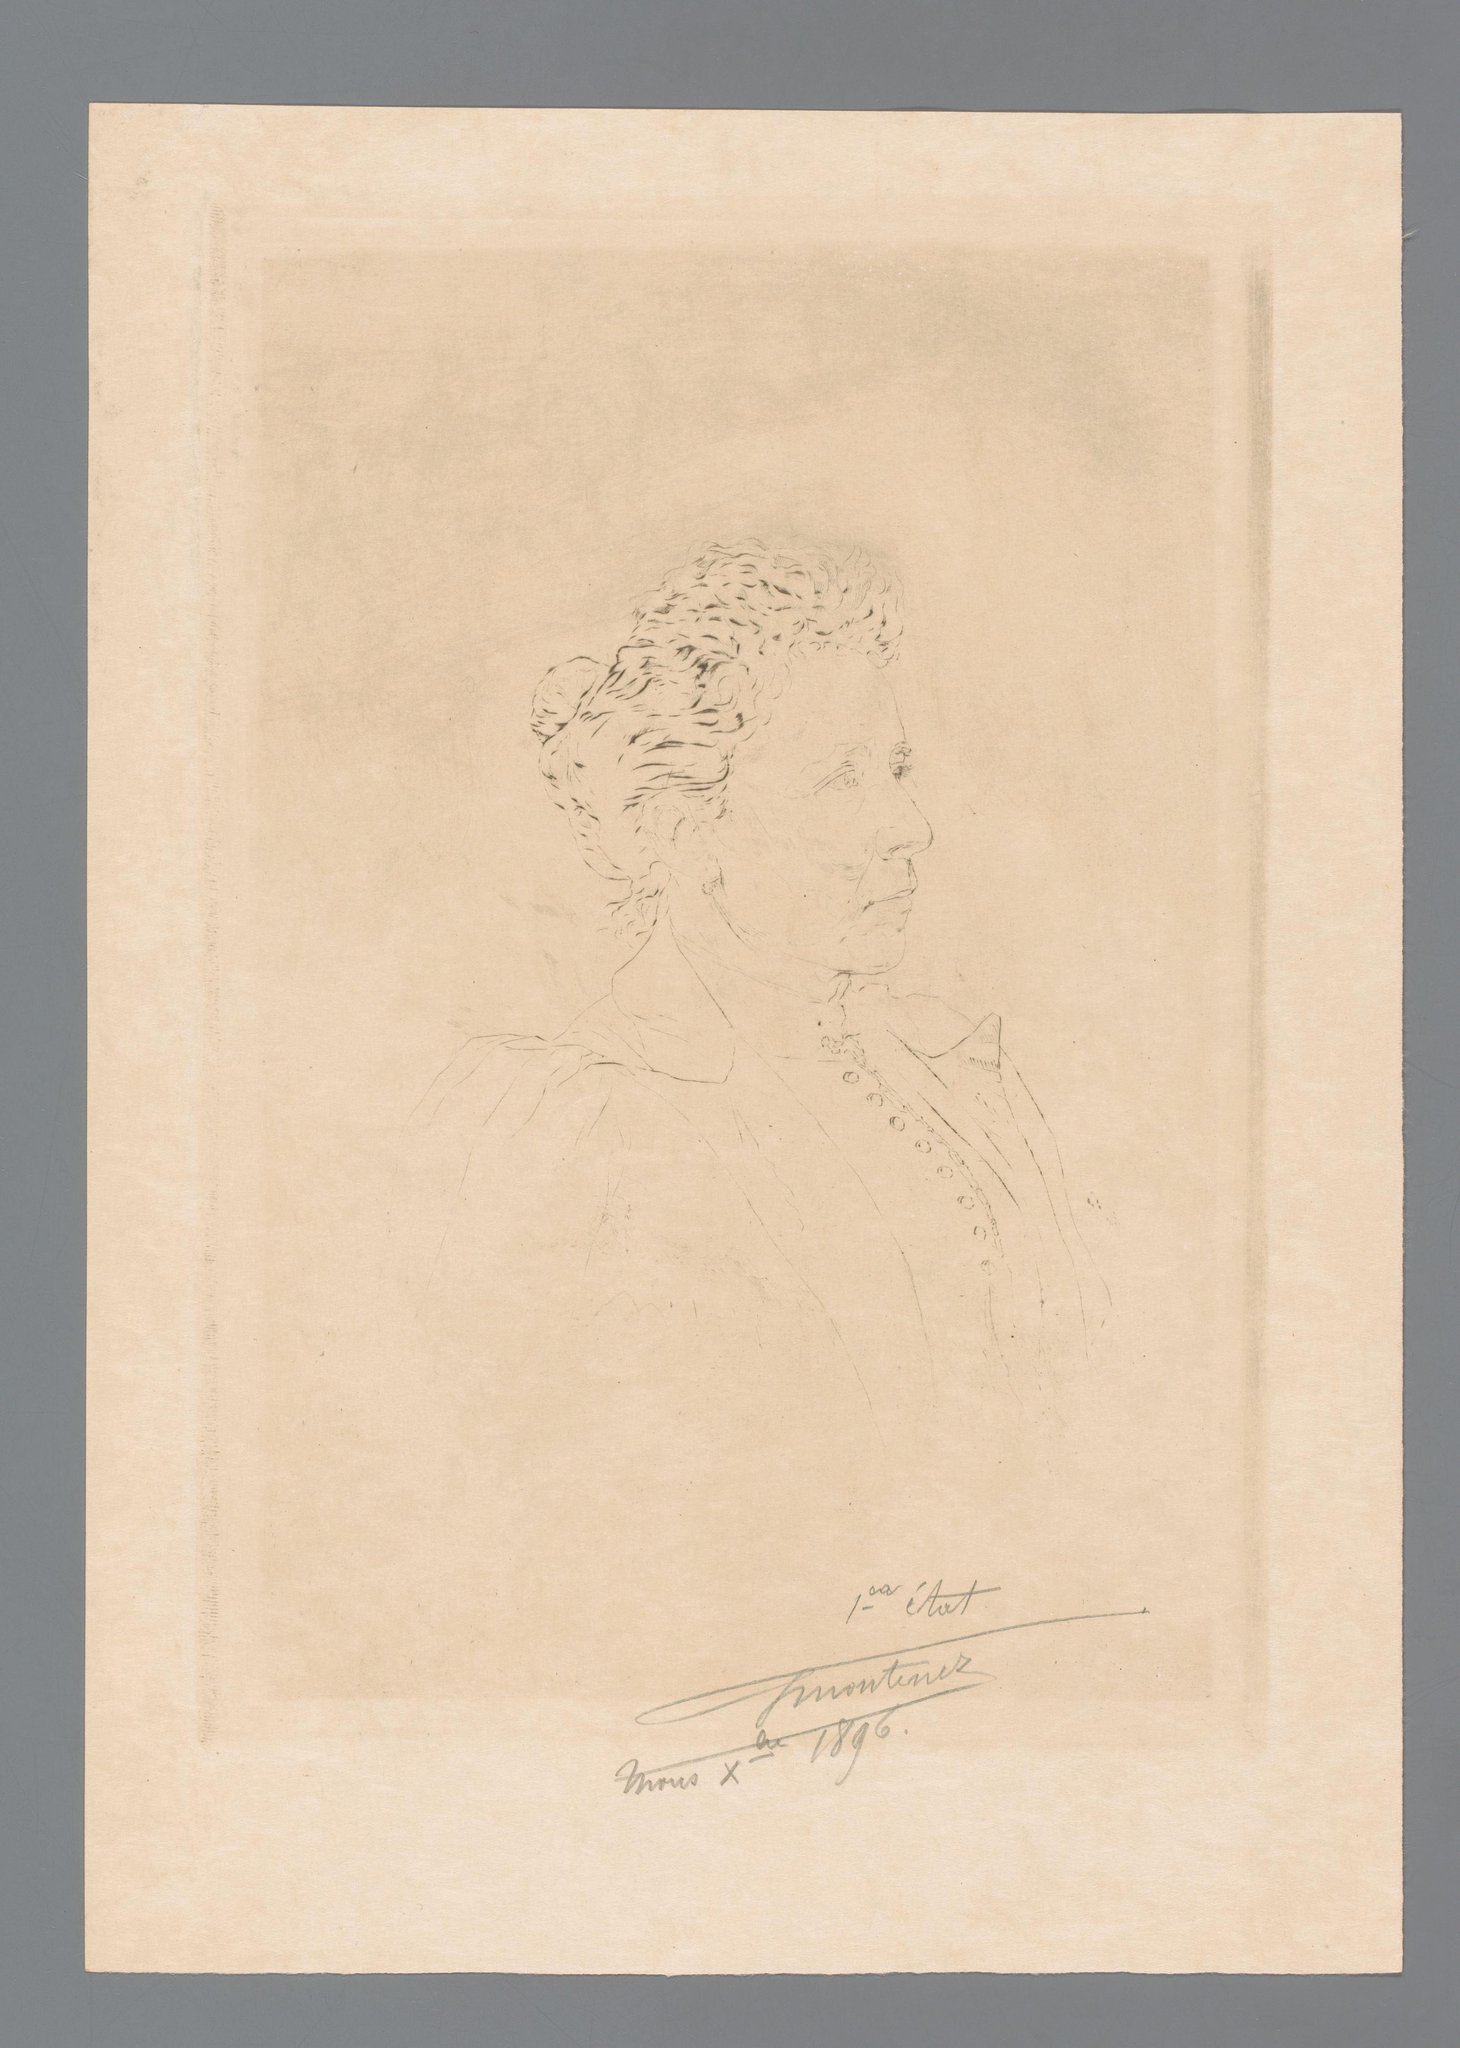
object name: print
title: Portret van een onbekende vrouw, mogelijk mevrouw Elle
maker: georges montenez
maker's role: print maker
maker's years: 1873-1930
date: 1896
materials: paper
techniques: drypoint, etching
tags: adult woman, historical persons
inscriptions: inscription: ‘1e état; Mons X en 1896’, collector's mark: Lugt 2228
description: In de inventaris getiteld: Portret van Mlle Elle.